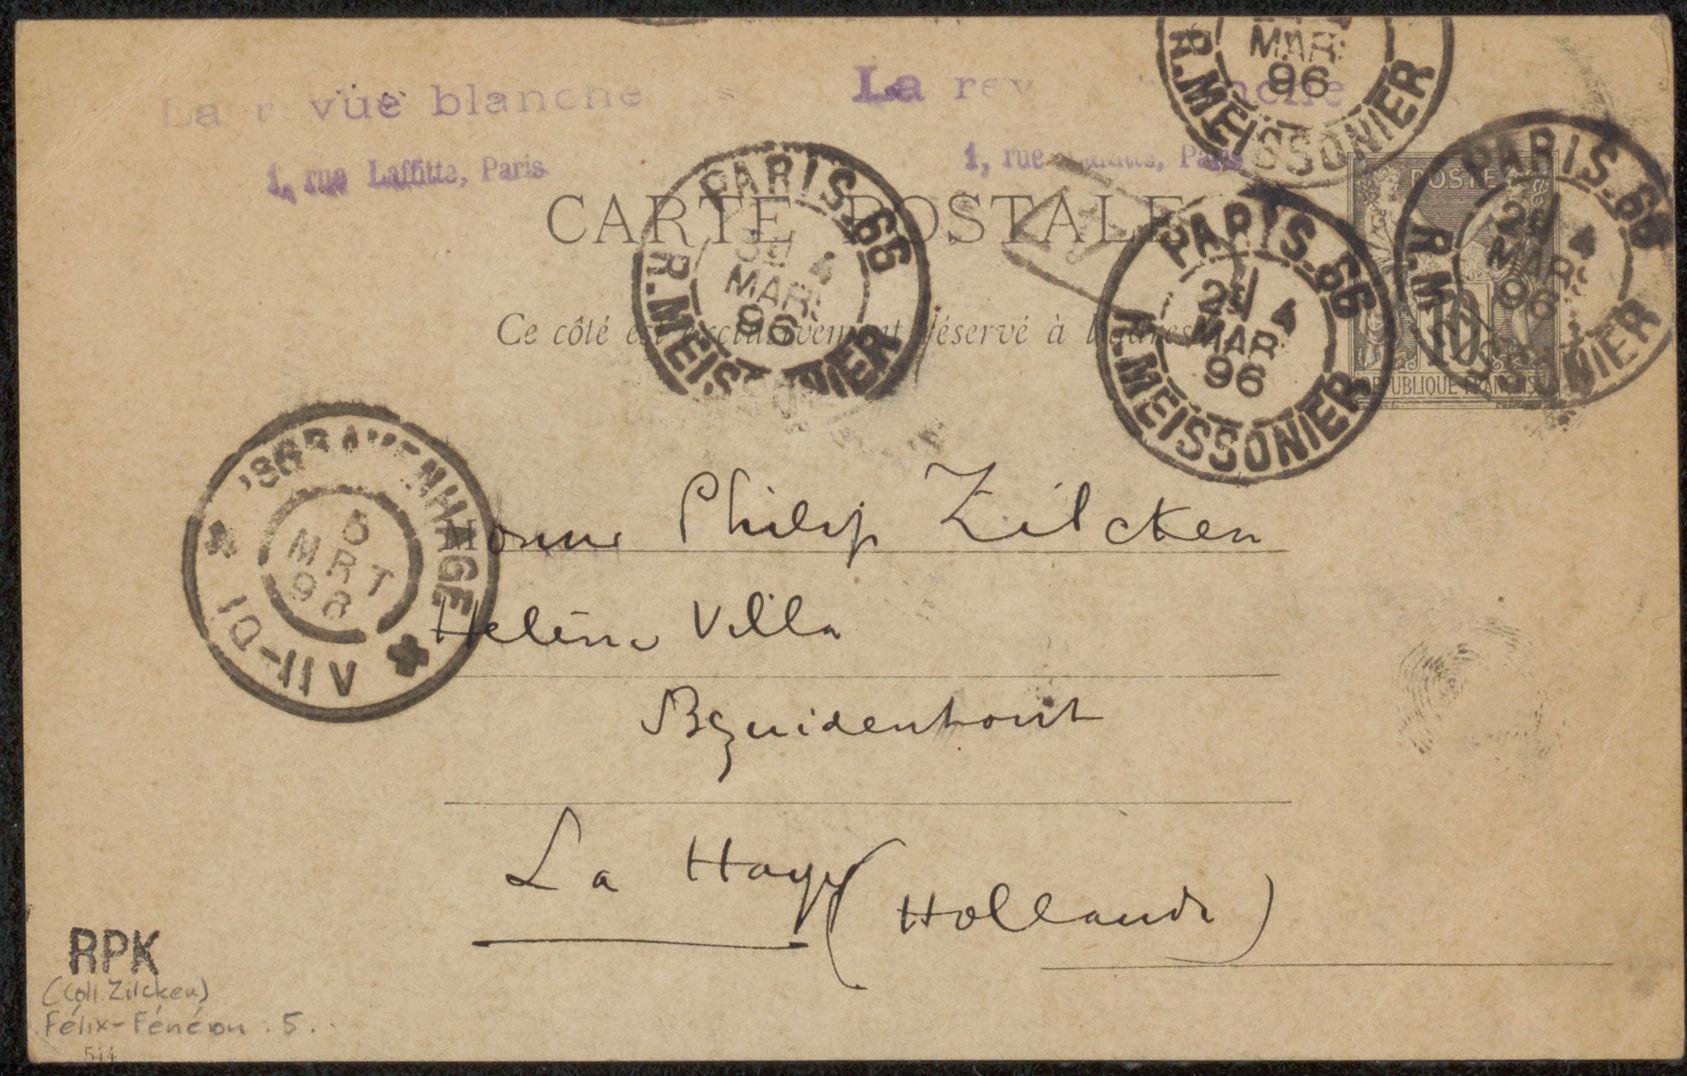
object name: postcard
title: Briefkaart aan Philip Zilcken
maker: félix fénéon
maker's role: handelaar, kunstcriticus, verzamelaar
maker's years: 1861-1944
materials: cardboard, ink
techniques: pen, writing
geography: paris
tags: the hague, draughtsman, philip zilcken, literature ~ arts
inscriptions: collector's mark: ‘RPK’, address: ‘La revue blanche/ 1, rue Laffitte, Paris’